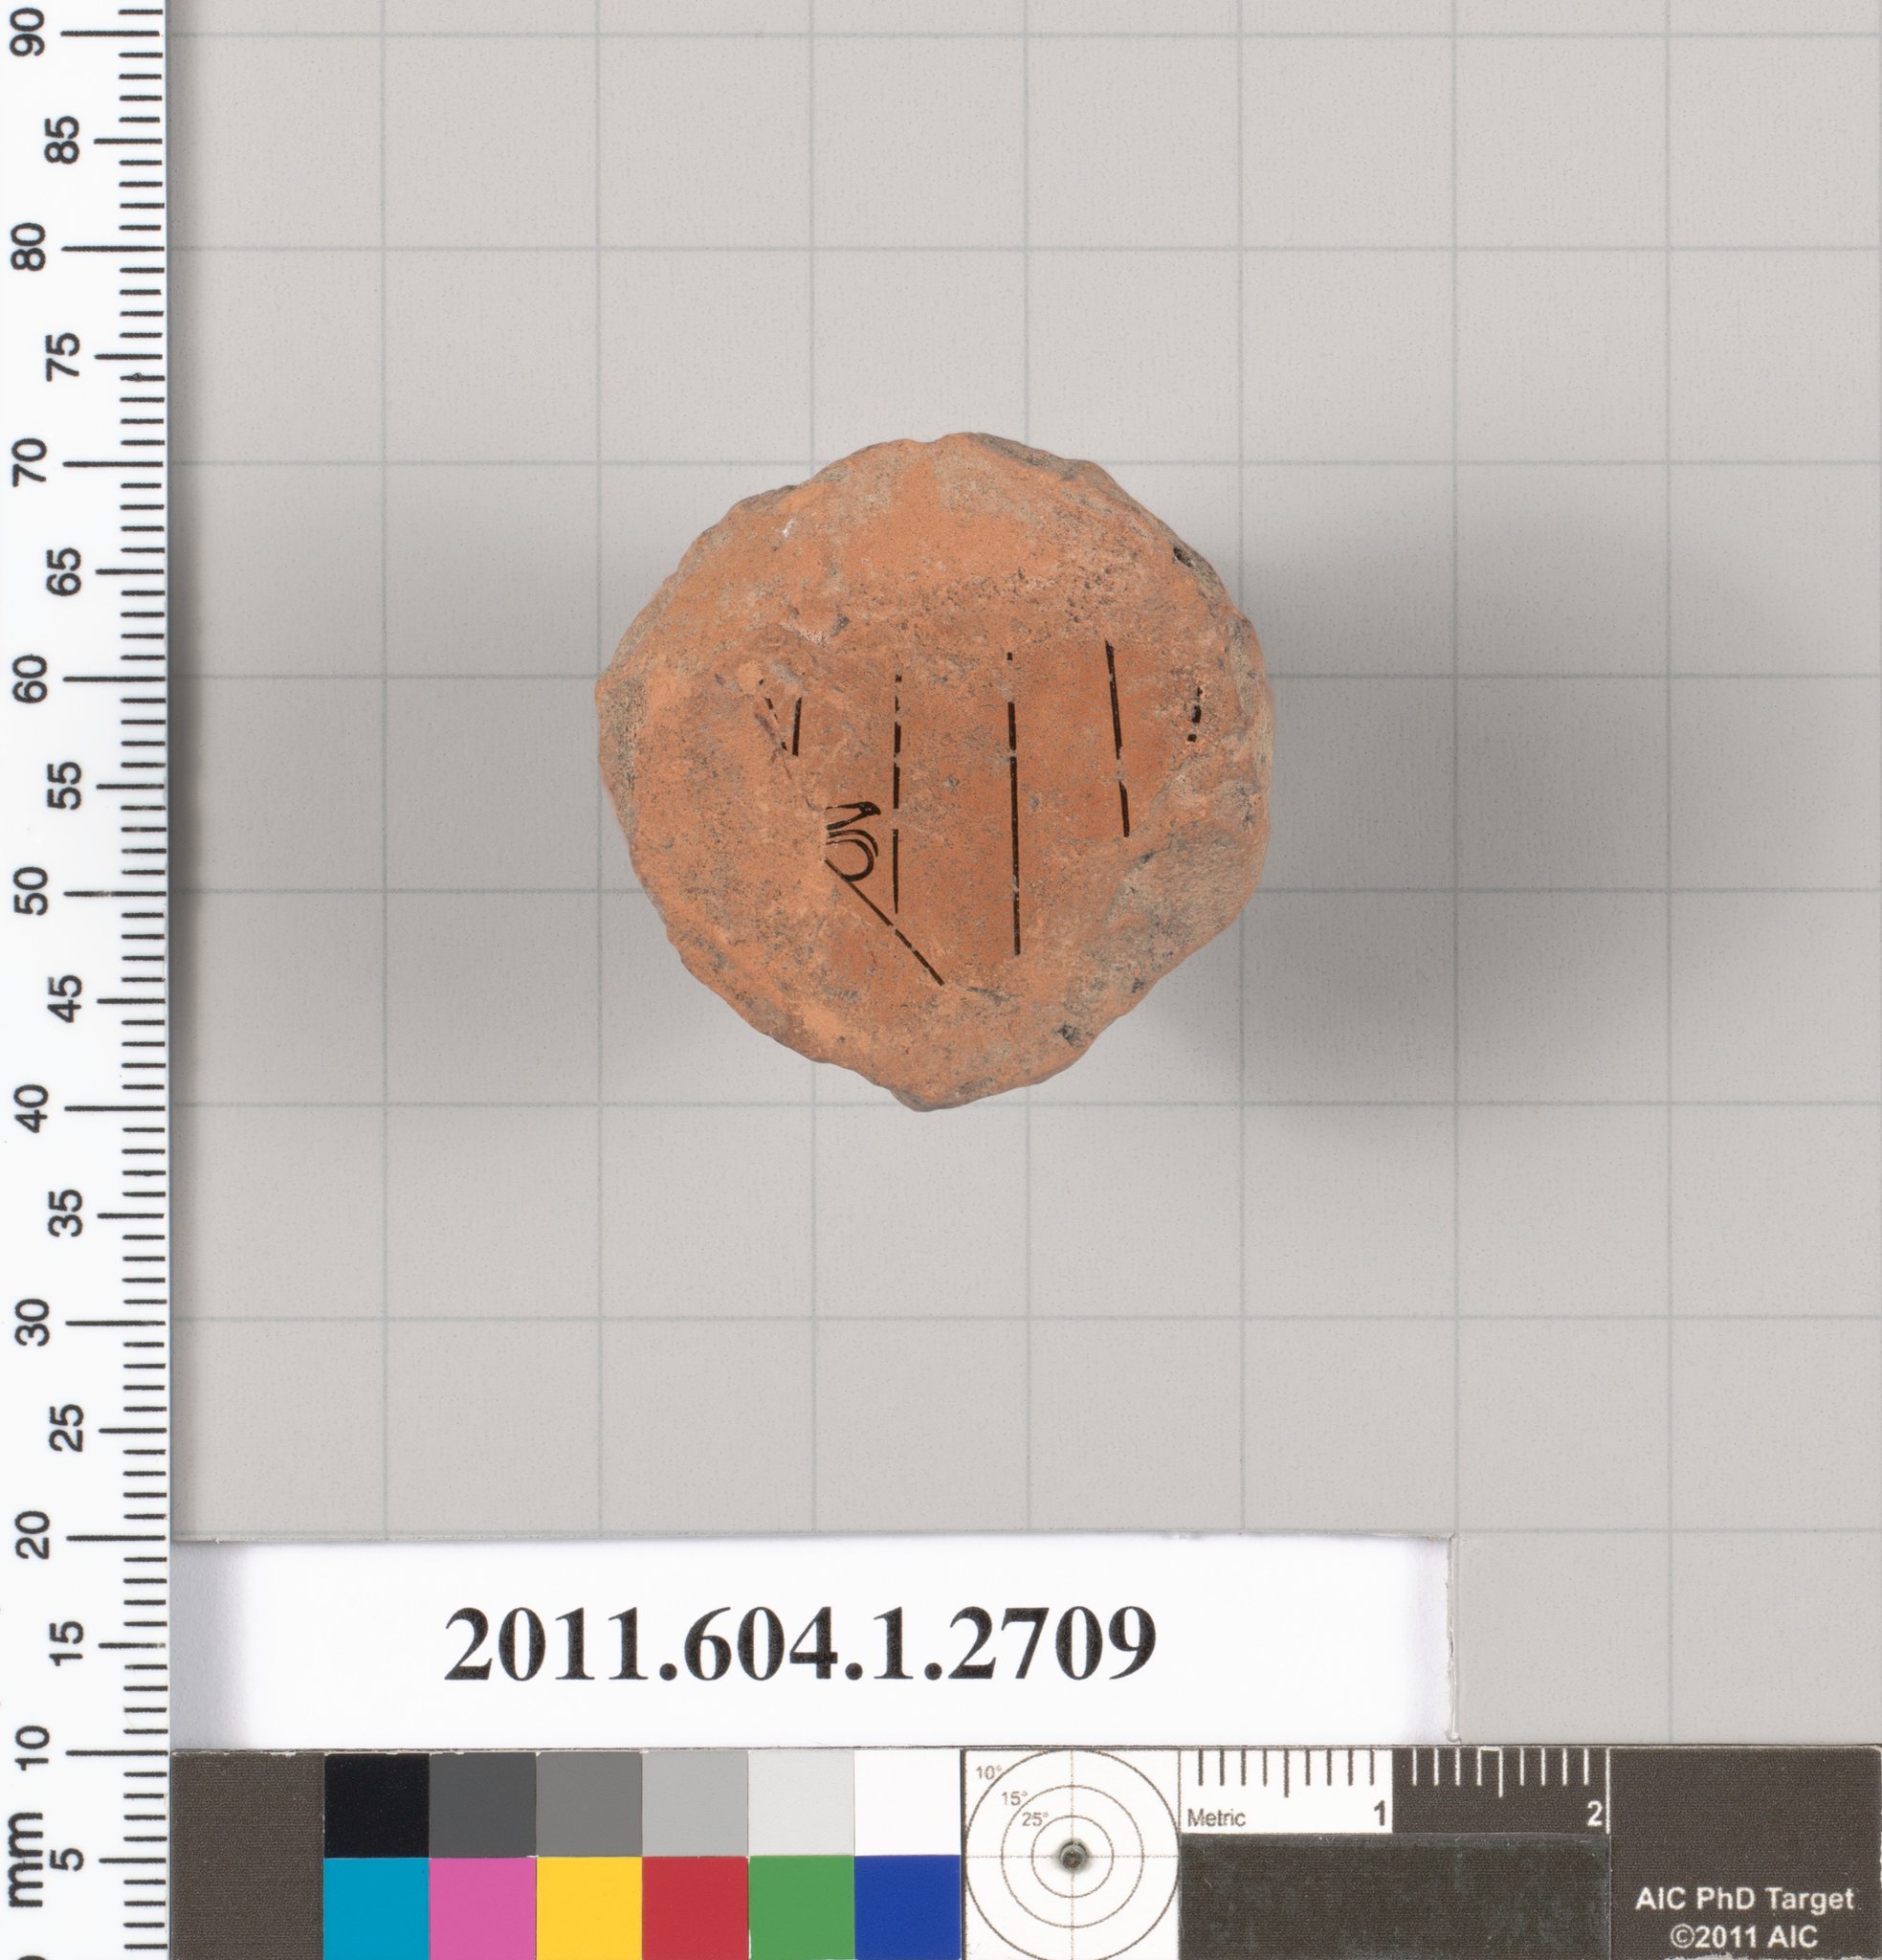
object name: kylix fragment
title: Terracotta fragment of a kylix (drinking cup)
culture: greek, attic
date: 475-451 BCE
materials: terracotta